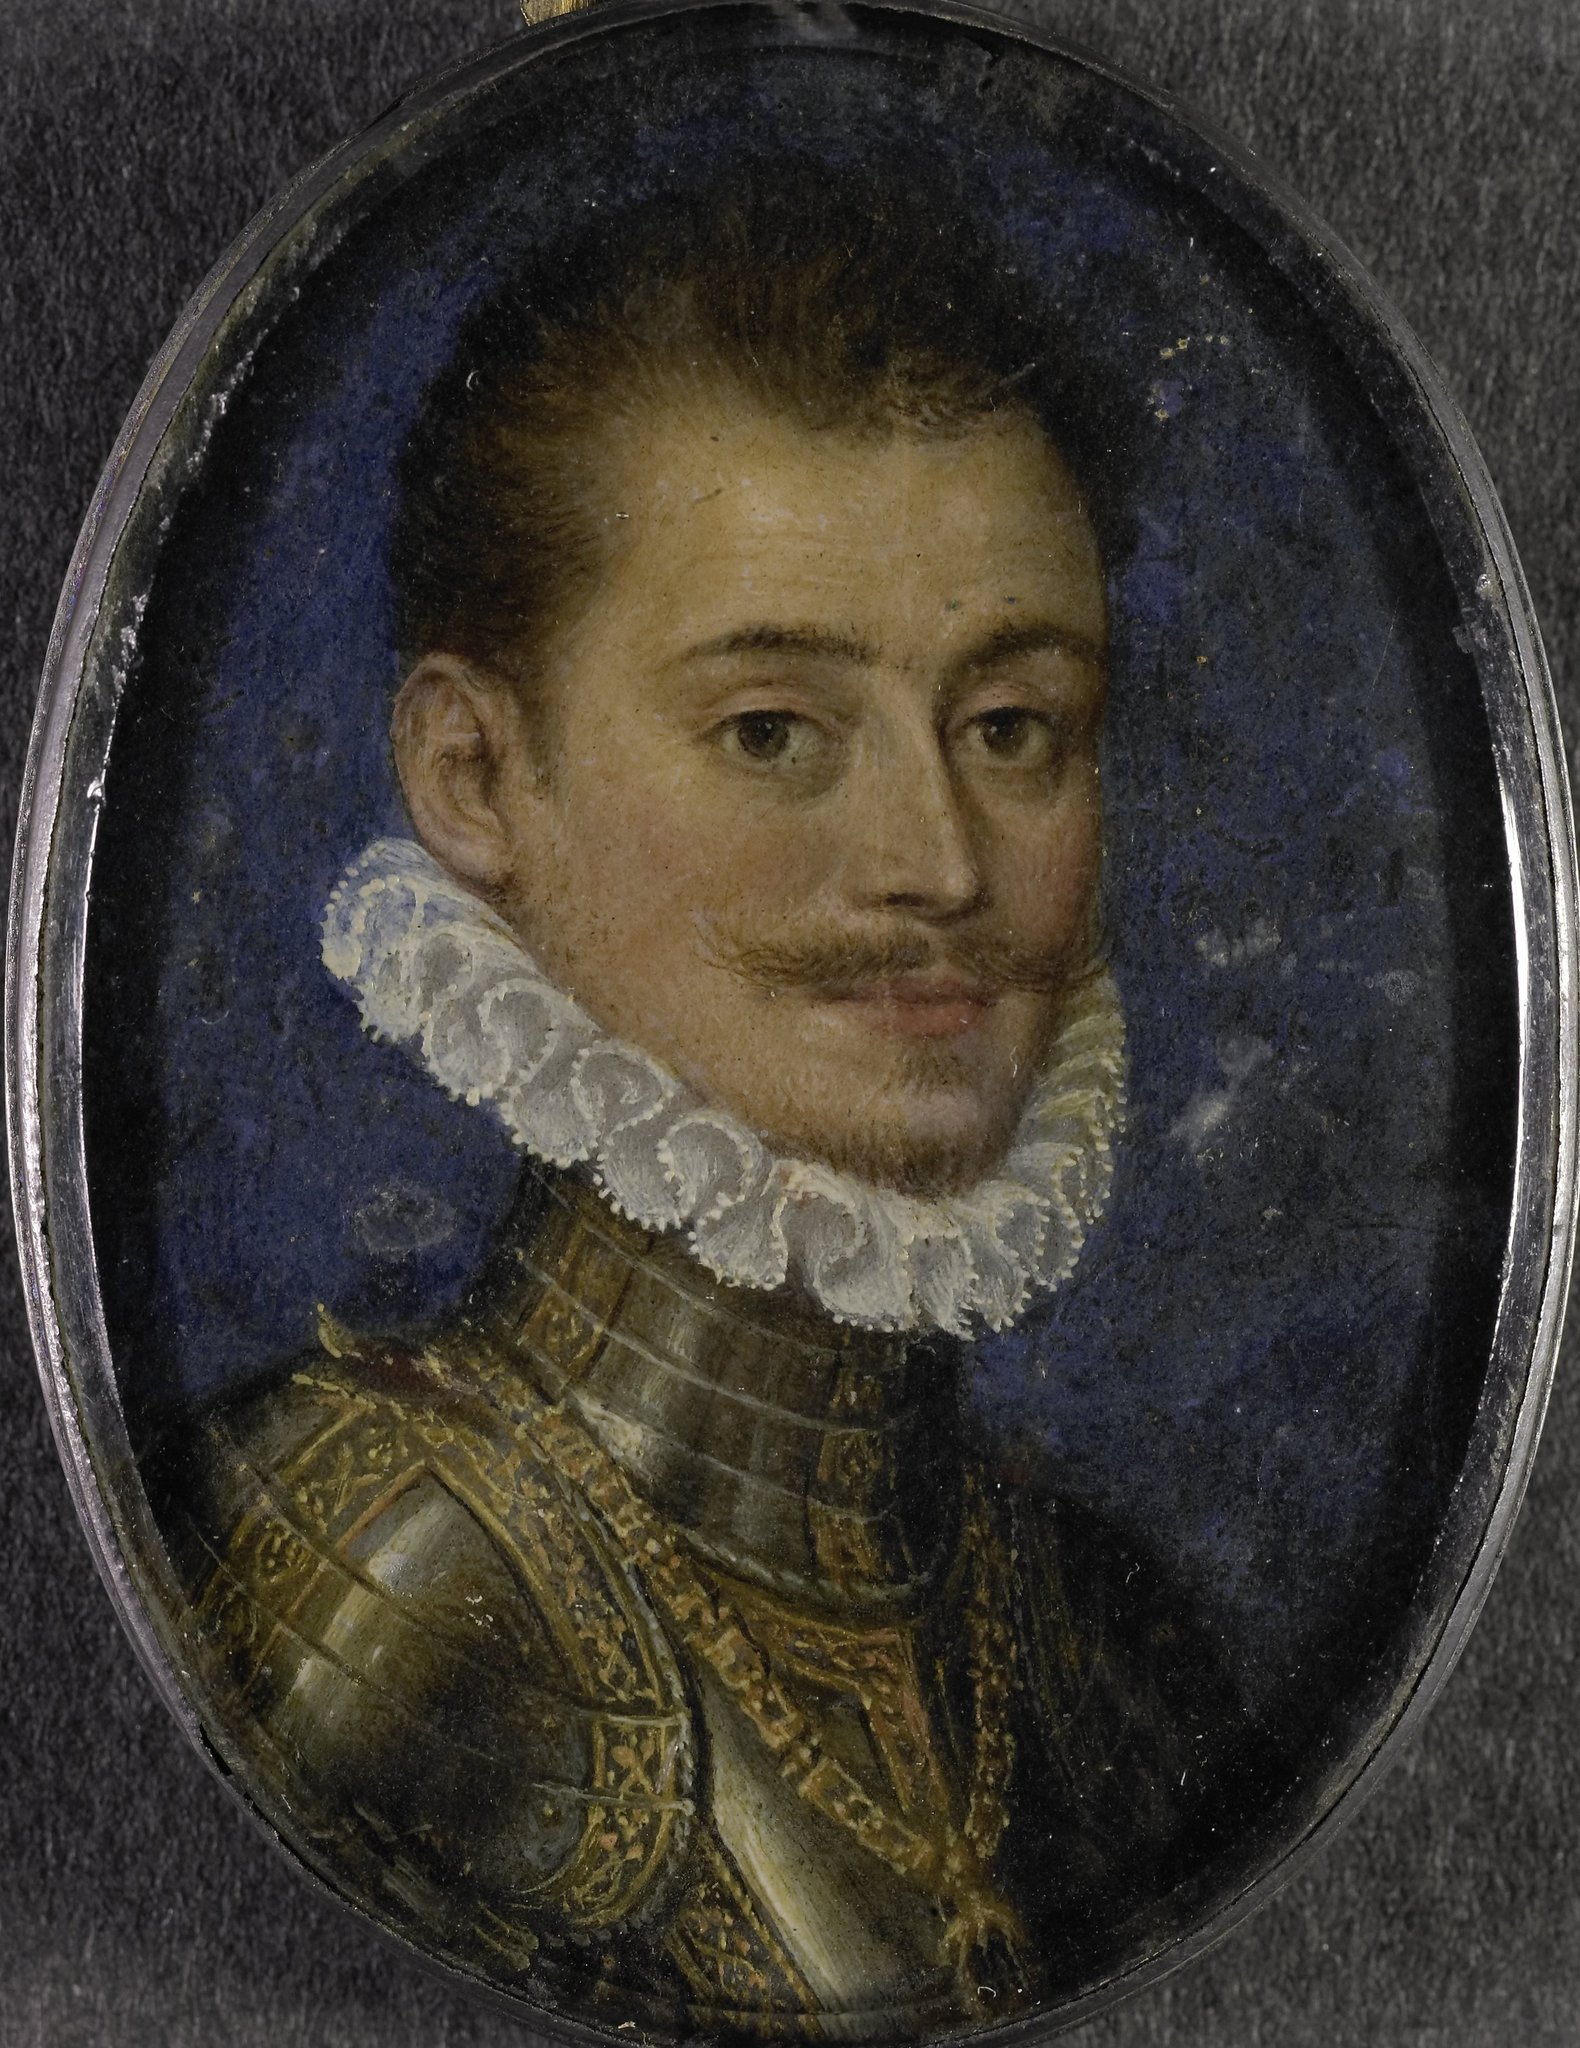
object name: painting, miniature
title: Don Juan van Oostenrijk (1547-1578). Landvoogd der Nederlanden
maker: Anonymous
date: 1560-1580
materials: copper, glass, oil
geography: southern netherlands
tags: don juan van oostenrijk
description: Don Juan of Austria (1547 - 87), Regent of the Netherlands. Flemish school. Oilpaint on copper, c. 1570.